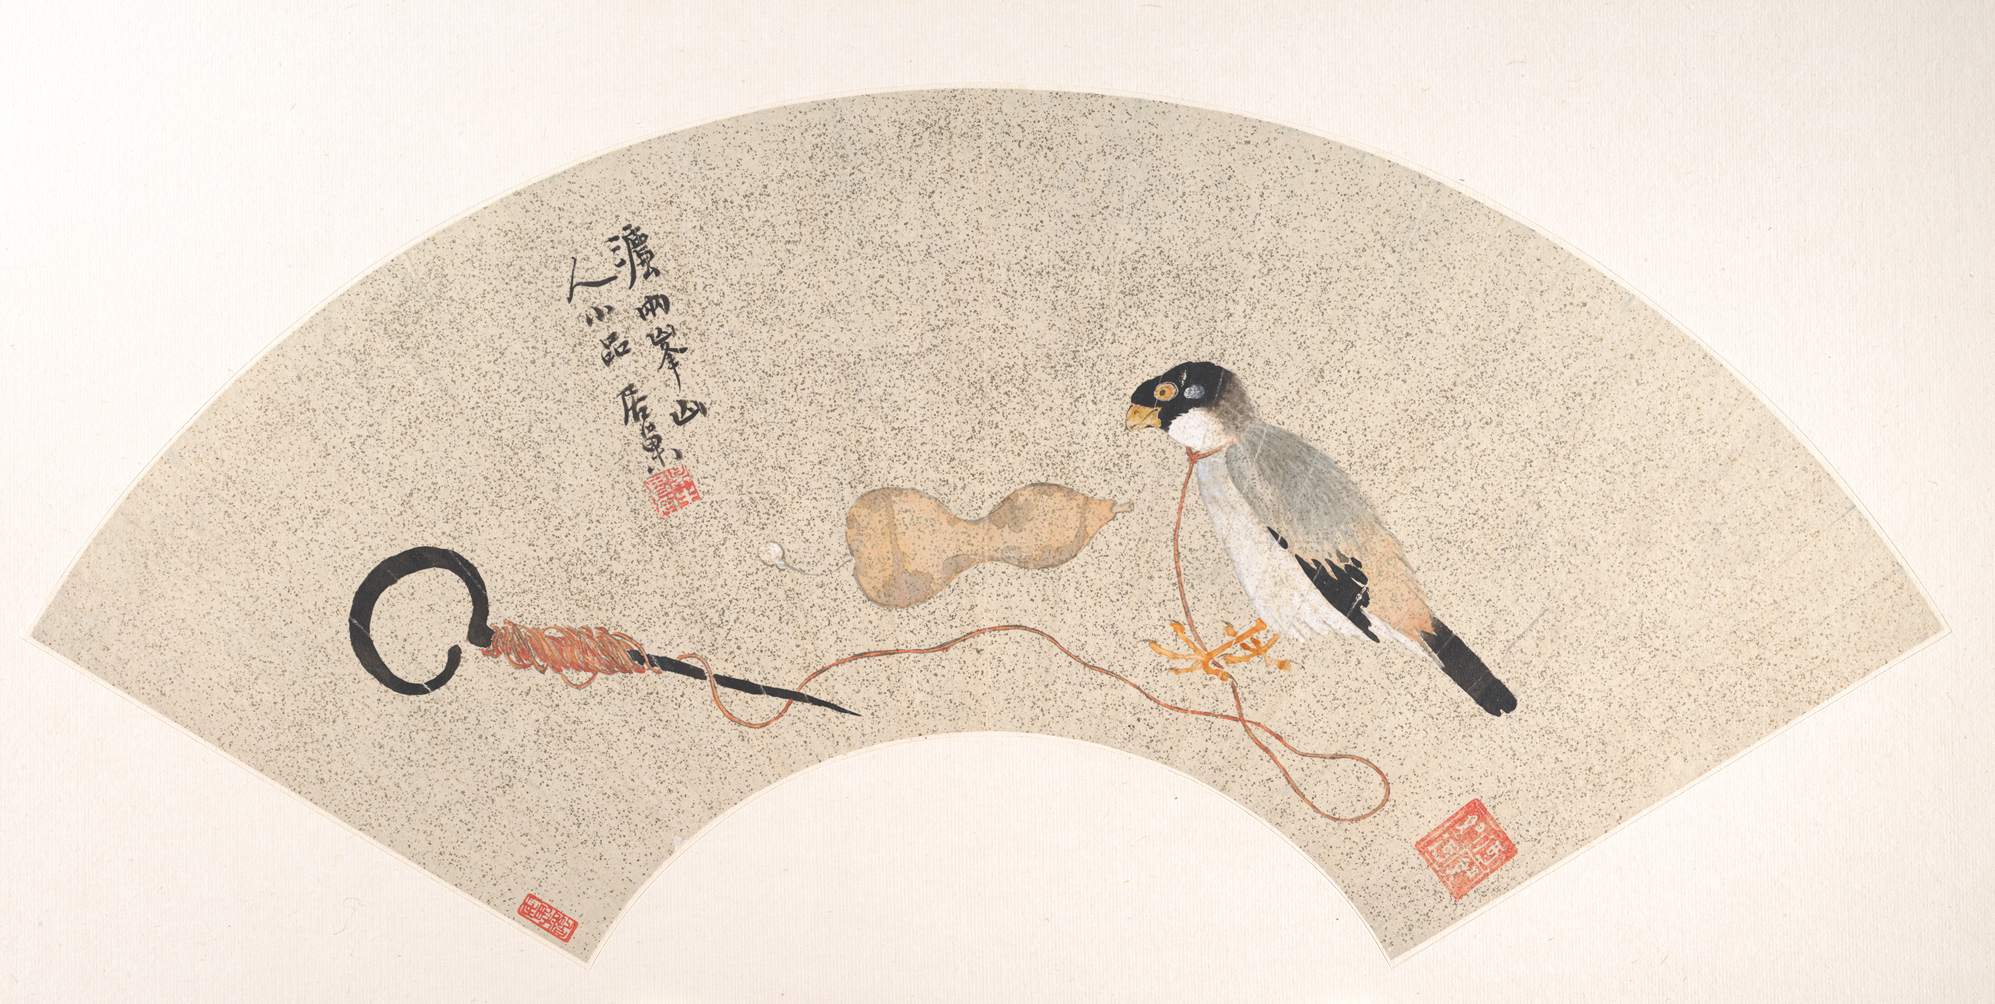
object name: folding fan mounted a an album leaf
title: Bird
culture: chinese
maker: ju chao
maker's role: artist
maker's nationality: chinese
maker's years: 1823-1889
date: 1823-1889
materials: gold, ink, paper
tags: birds